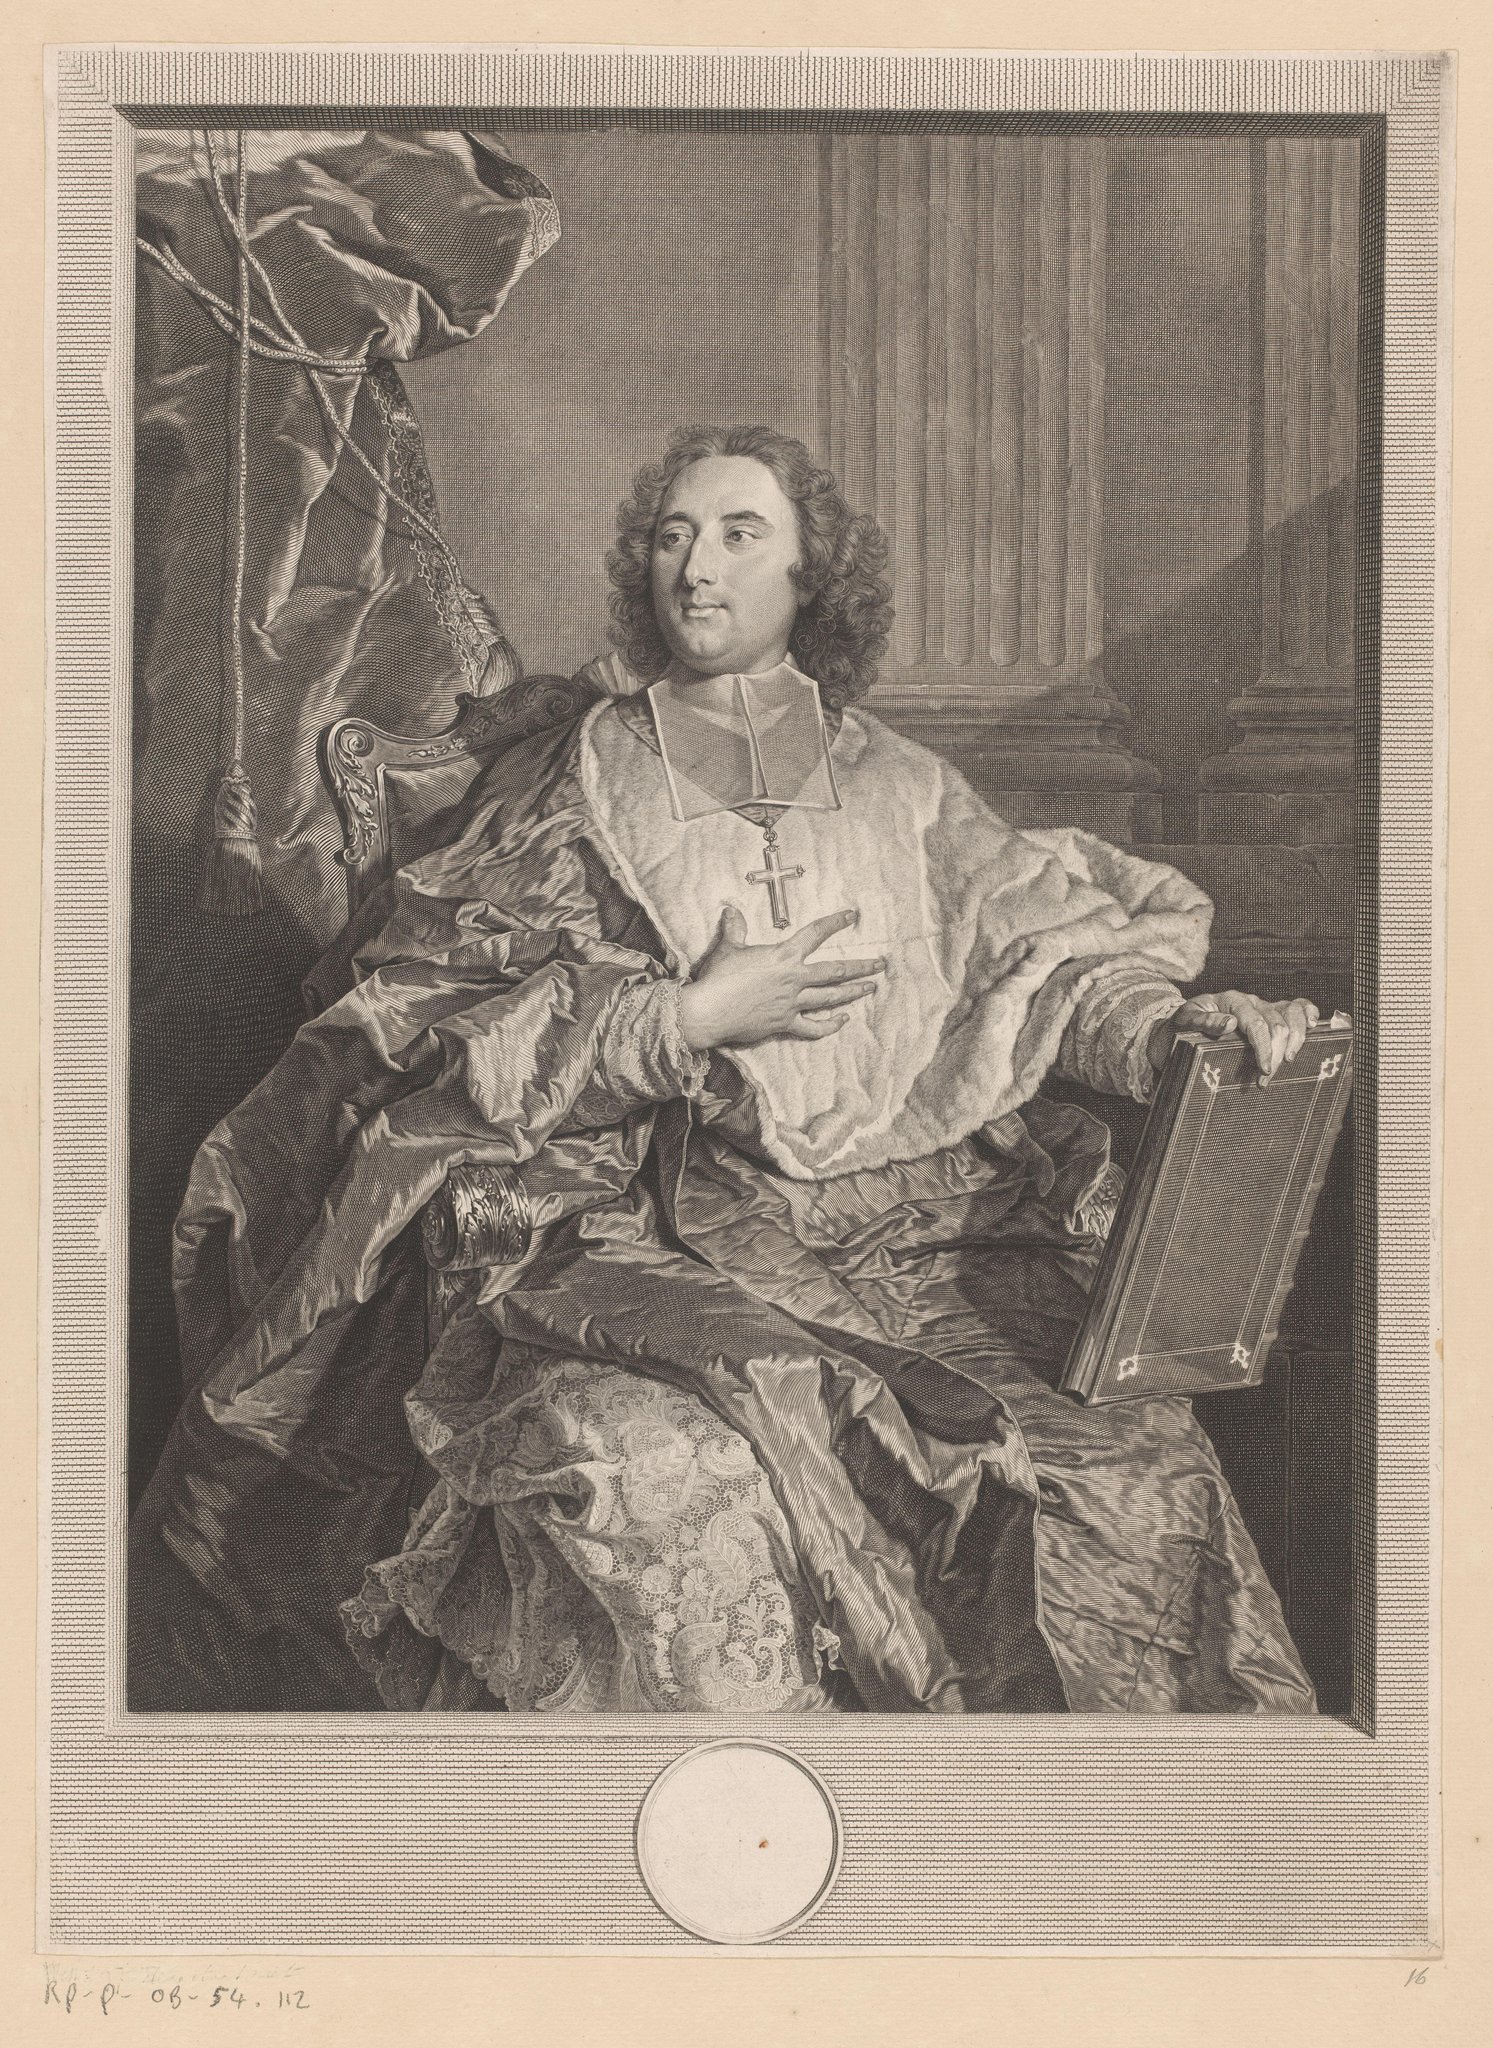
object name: print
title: Portret van Louis Charles de Saint-Albin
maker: georg friedrich schmidt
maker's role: draughtsman, print maker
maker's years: 1712-1775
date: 1741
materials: paper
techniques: engraving, etching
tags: paris, theologian, historical persons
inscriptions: collector's mark: Lugt 240